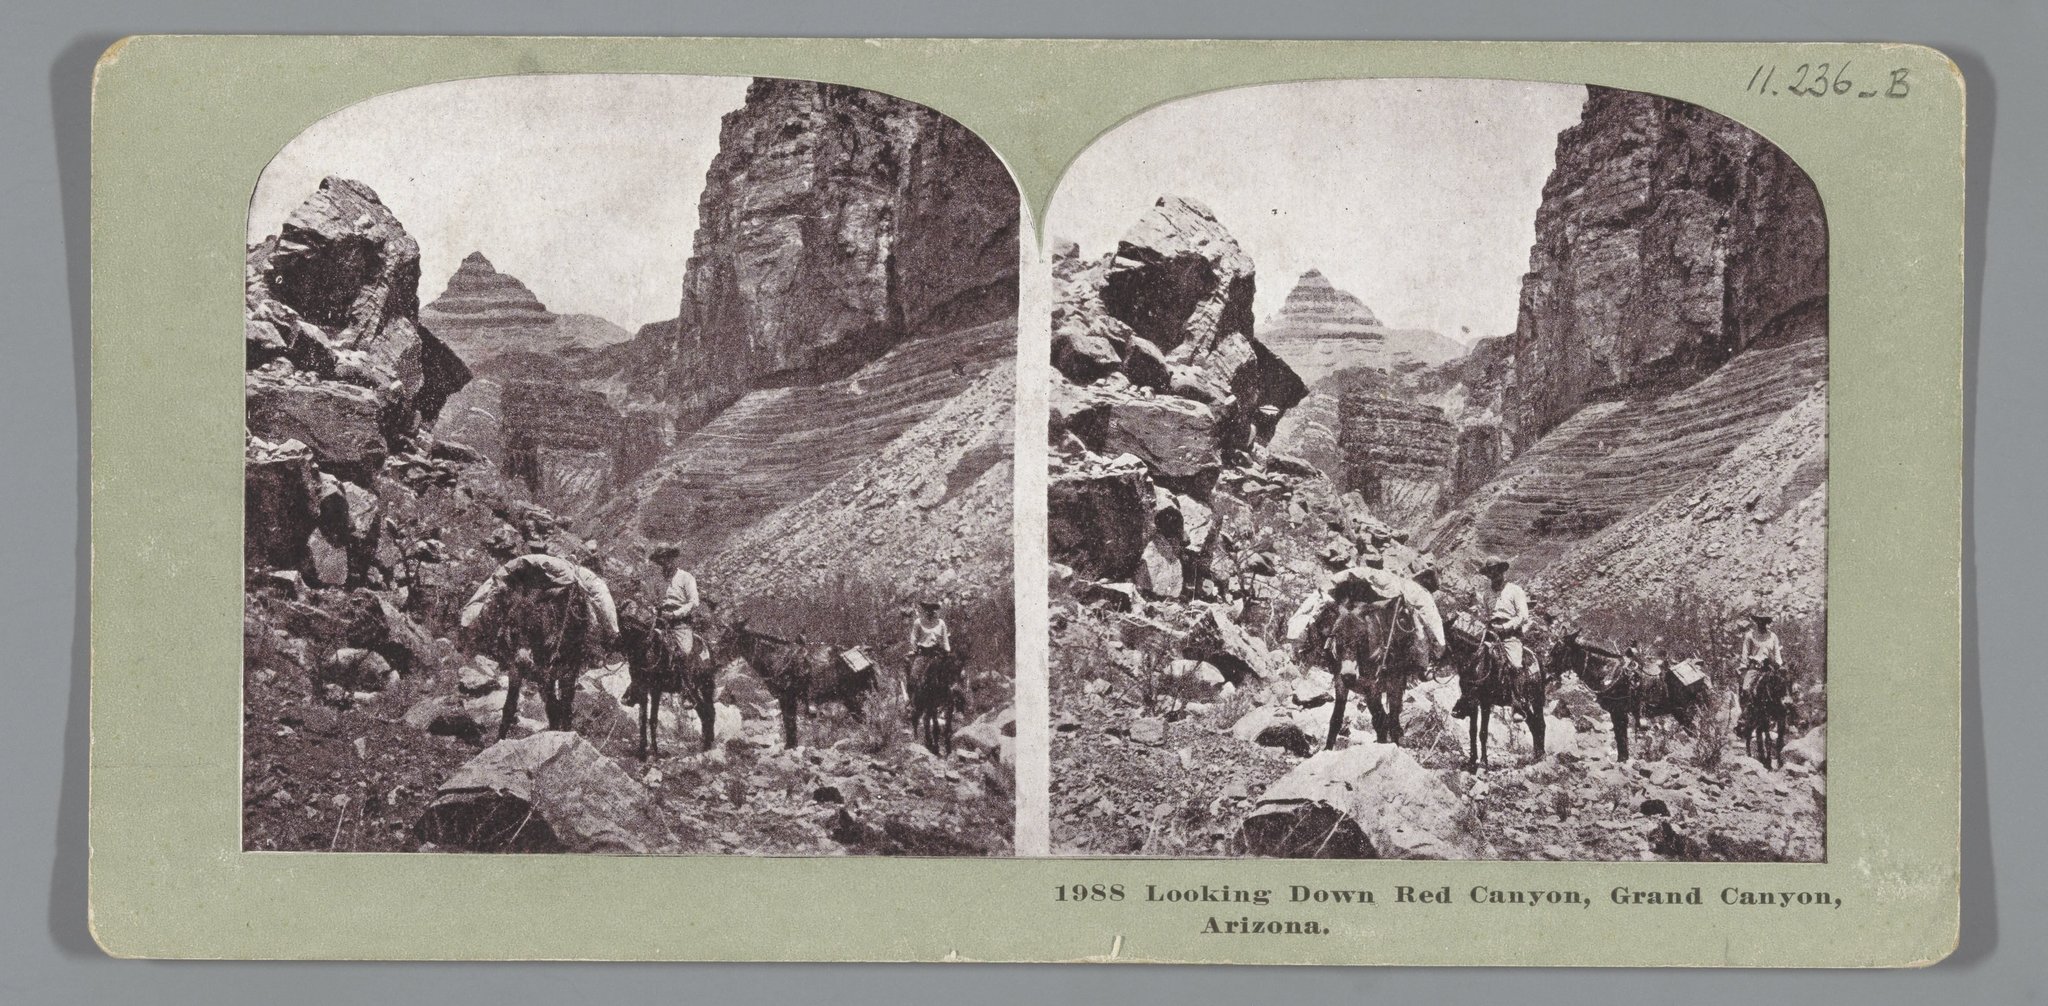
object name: photomechanical print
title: Ruiters te paard nabij Red Canyon, Arizona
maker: Anonymous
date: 1898-1930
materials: cardboard, photographic support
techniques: autotype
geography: grand canyon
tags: riding a horse, ass, or mule; rider, horseman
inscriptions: number: ‘1988’